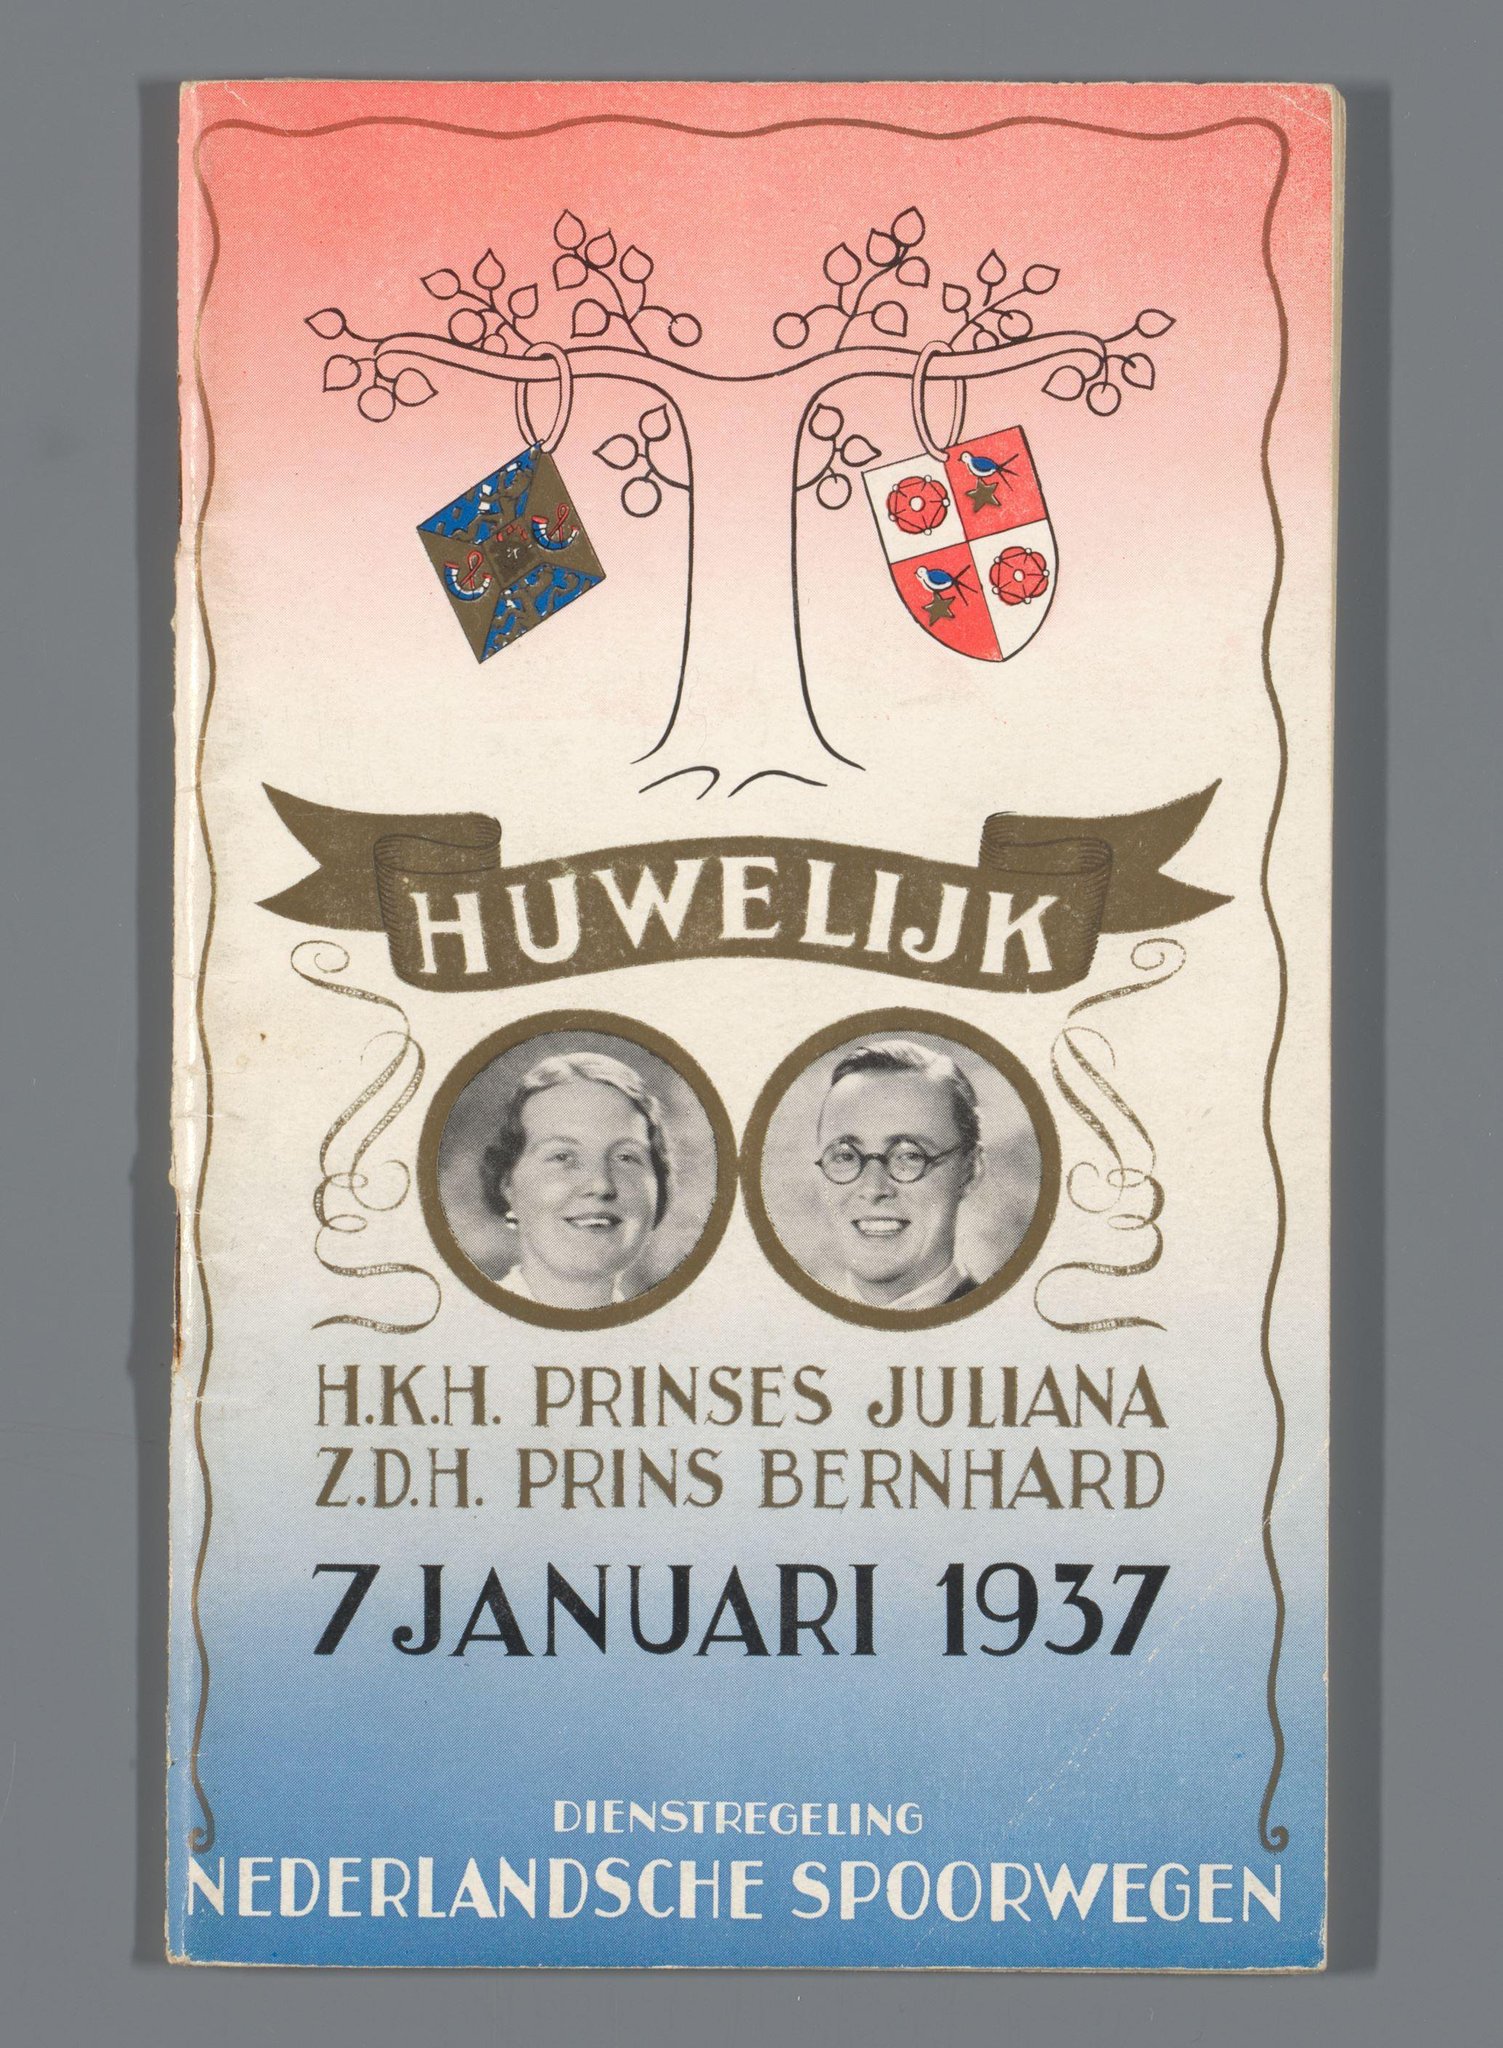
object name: brochure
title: Huwelijk / HKH prinses Juliana / ZDH prins Bernhard / 7 januari 1937; Dienstregeling Nederlandse Spoorwegen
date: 1937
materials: paper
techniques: printing, stapling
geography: utrecht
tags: utrecht, bernhard (prins der nederlanden), the hague, juliana of the netherlands, netherlands, amsterdam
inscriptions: date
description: 96 pp in dik papieren omslag. Gedateerd; titelp.: 7 januari 1937.